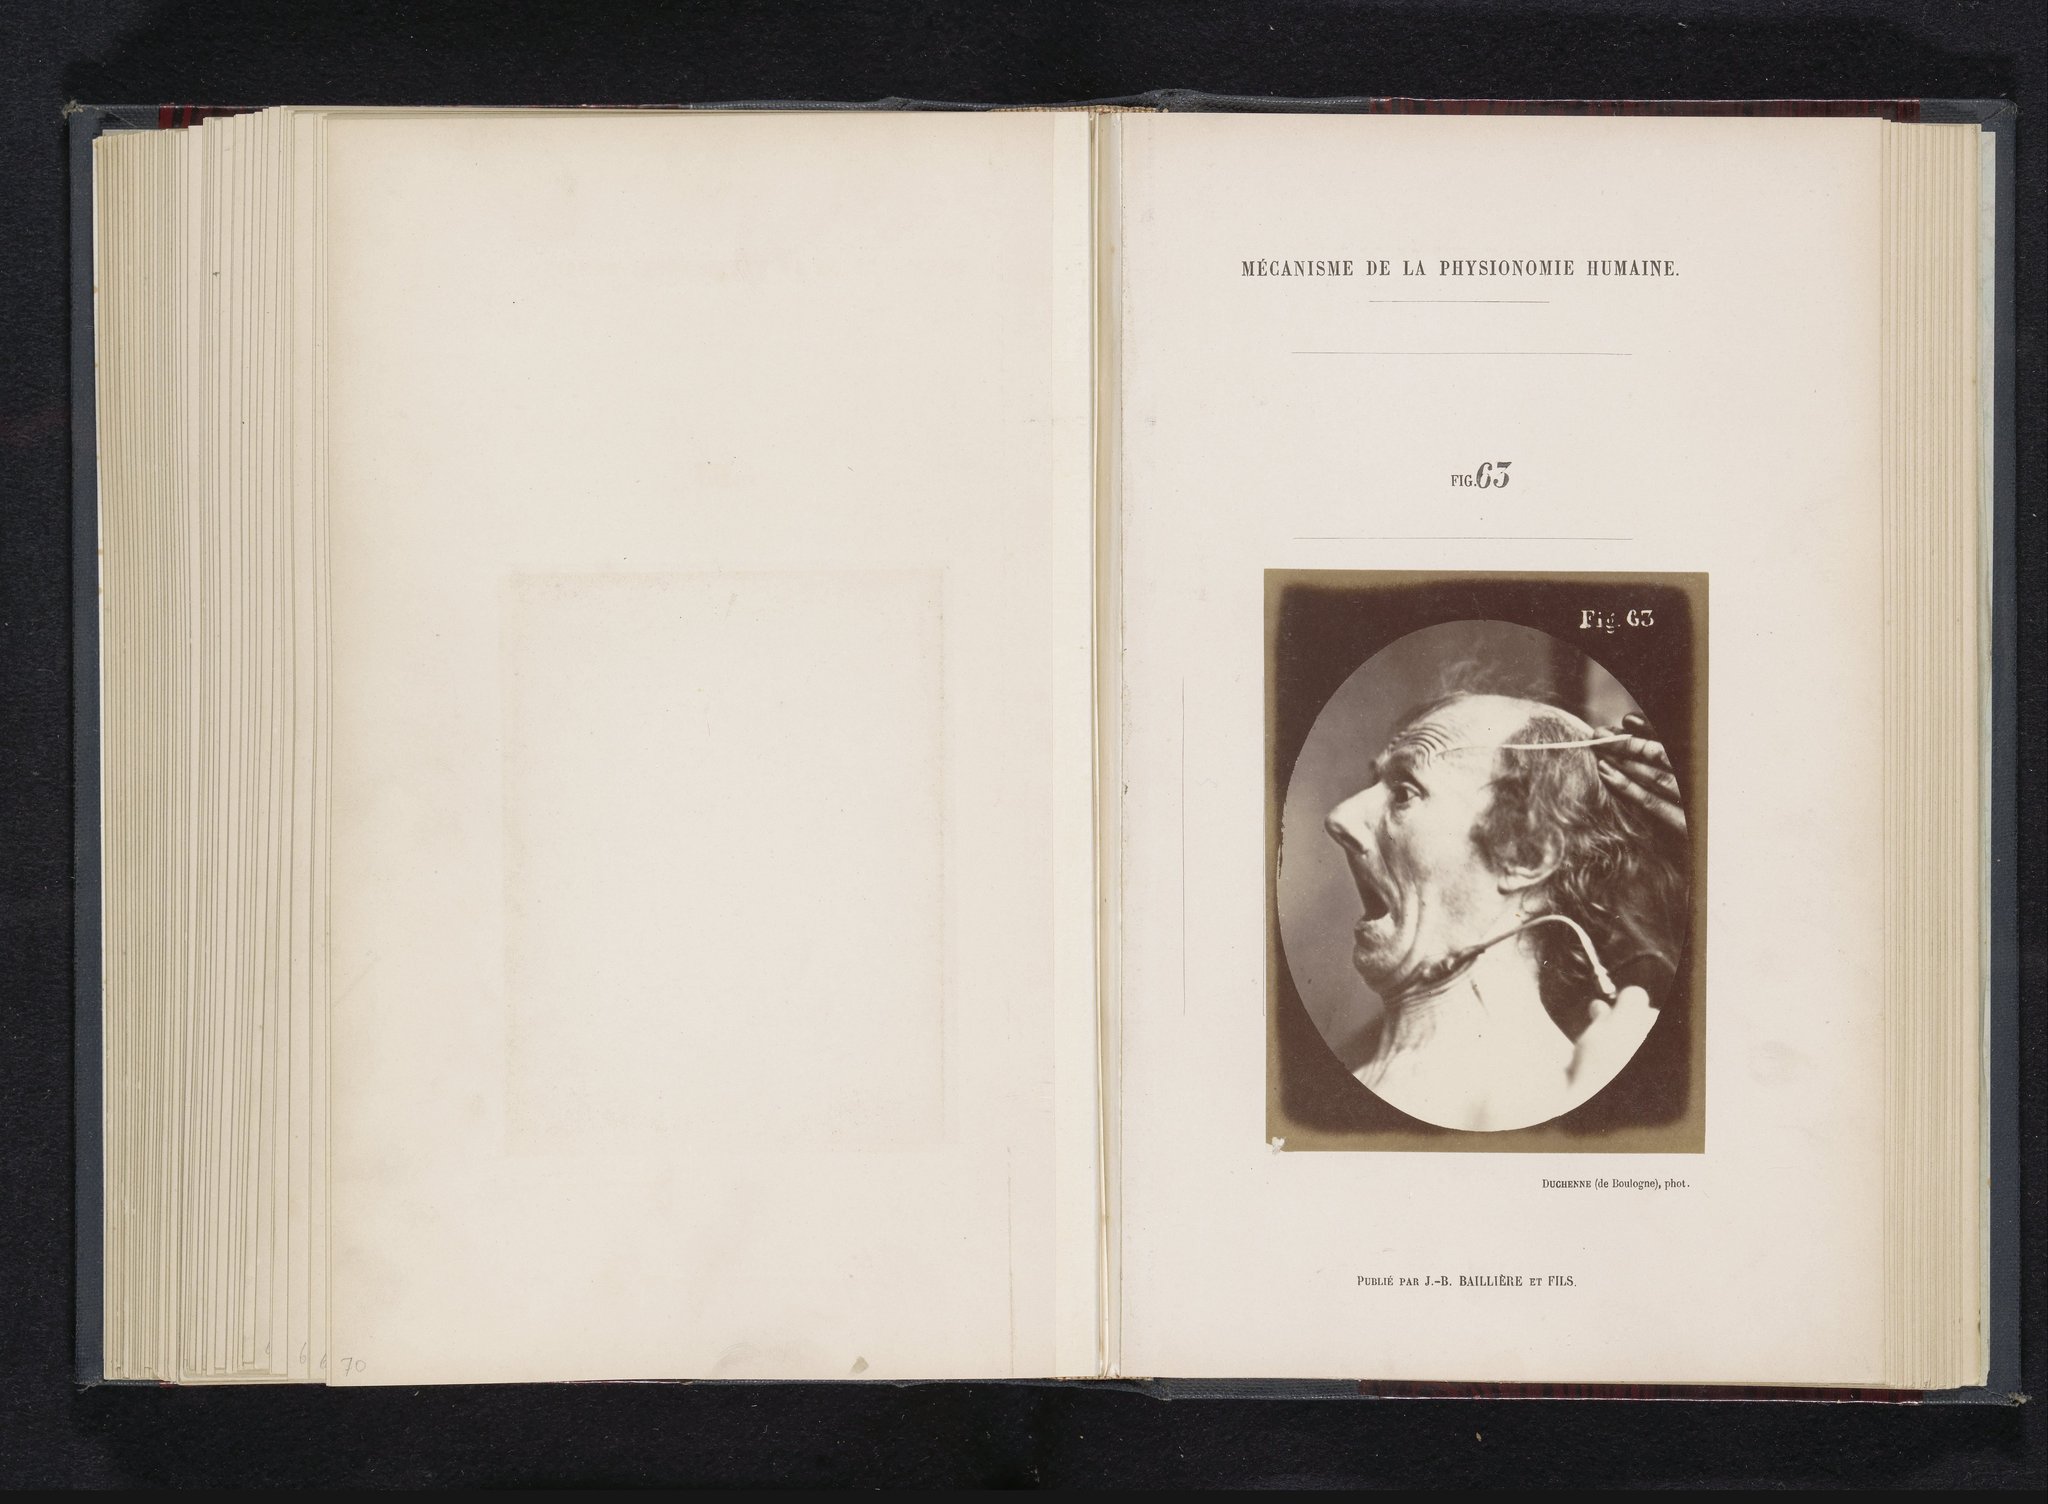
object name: photograph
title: Portret van een proefpersoon tijdens elektrostimulatie: 'un vieillard'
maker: guillaume benjamin amand duchenne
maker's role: fotograaf, medicus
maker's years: 1806-1875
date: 1860-1862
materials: paper, photographic support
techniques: albumen print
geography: france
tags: face, physiology and anatomy ~ nervous system, neurology, physiology and anatomy, old man, morphology of facial expression, physiognomy, experiment, test ~ science and technology, france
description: Ongenummerde pagina met foto 63 uit Mécanisme de la physionomie humaine ou analyse électro-physiologique de l'expression des passions (Atlas).